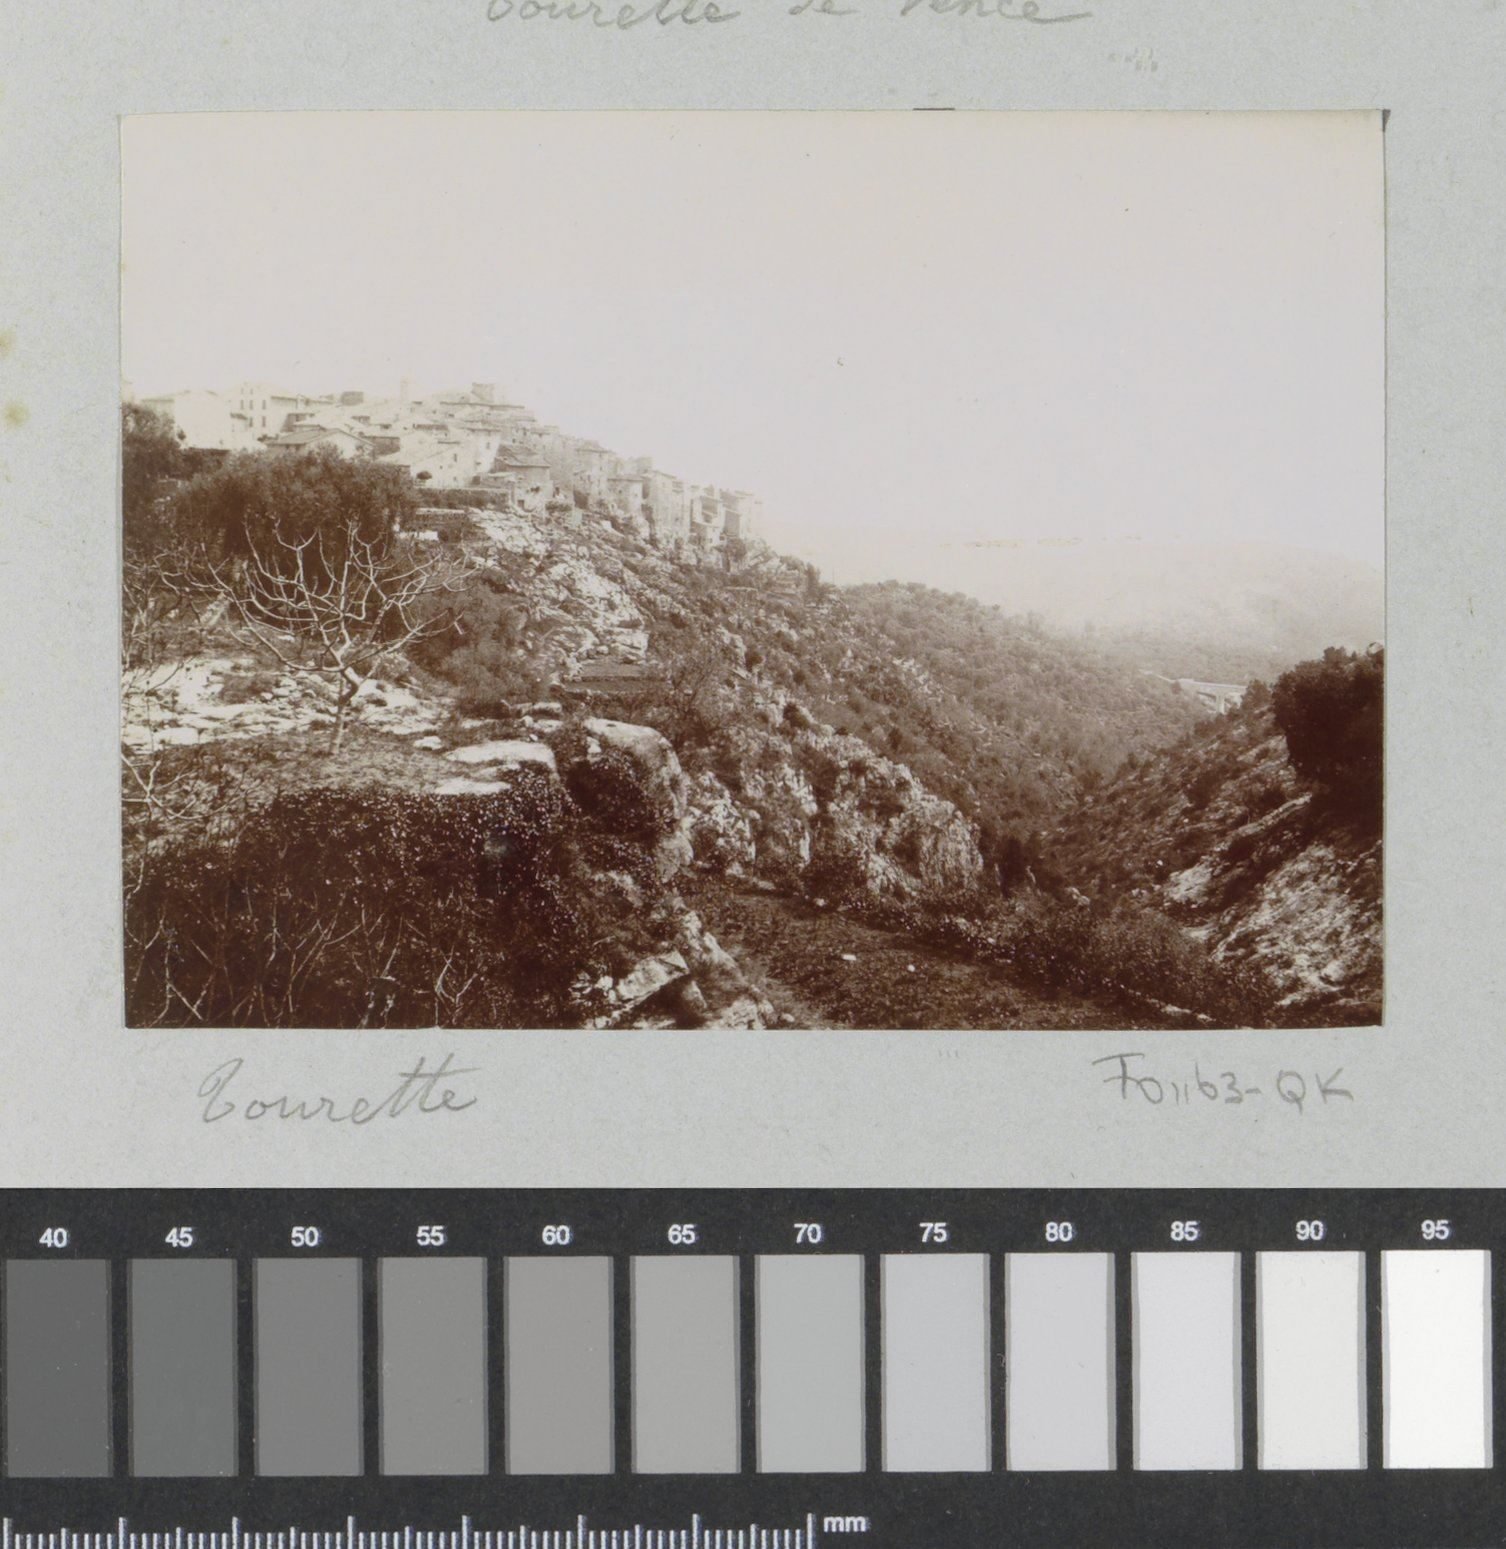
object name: photograph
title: Gezicht op Tourrettes-lès-Vence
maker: delizy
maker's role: manufacturer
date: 1903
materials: paper, photographic support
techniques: gelatin silver print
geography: tourrettes-lès-vence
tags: prospect of village, silhouette of village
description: Onderdeel van Fotoalbum van een Franse amateurfotograaf met opnames van uitstapjes in Frankrijk, Spanje, België, Luxemburg en Nederland, de eerste automobielen en autoraces.